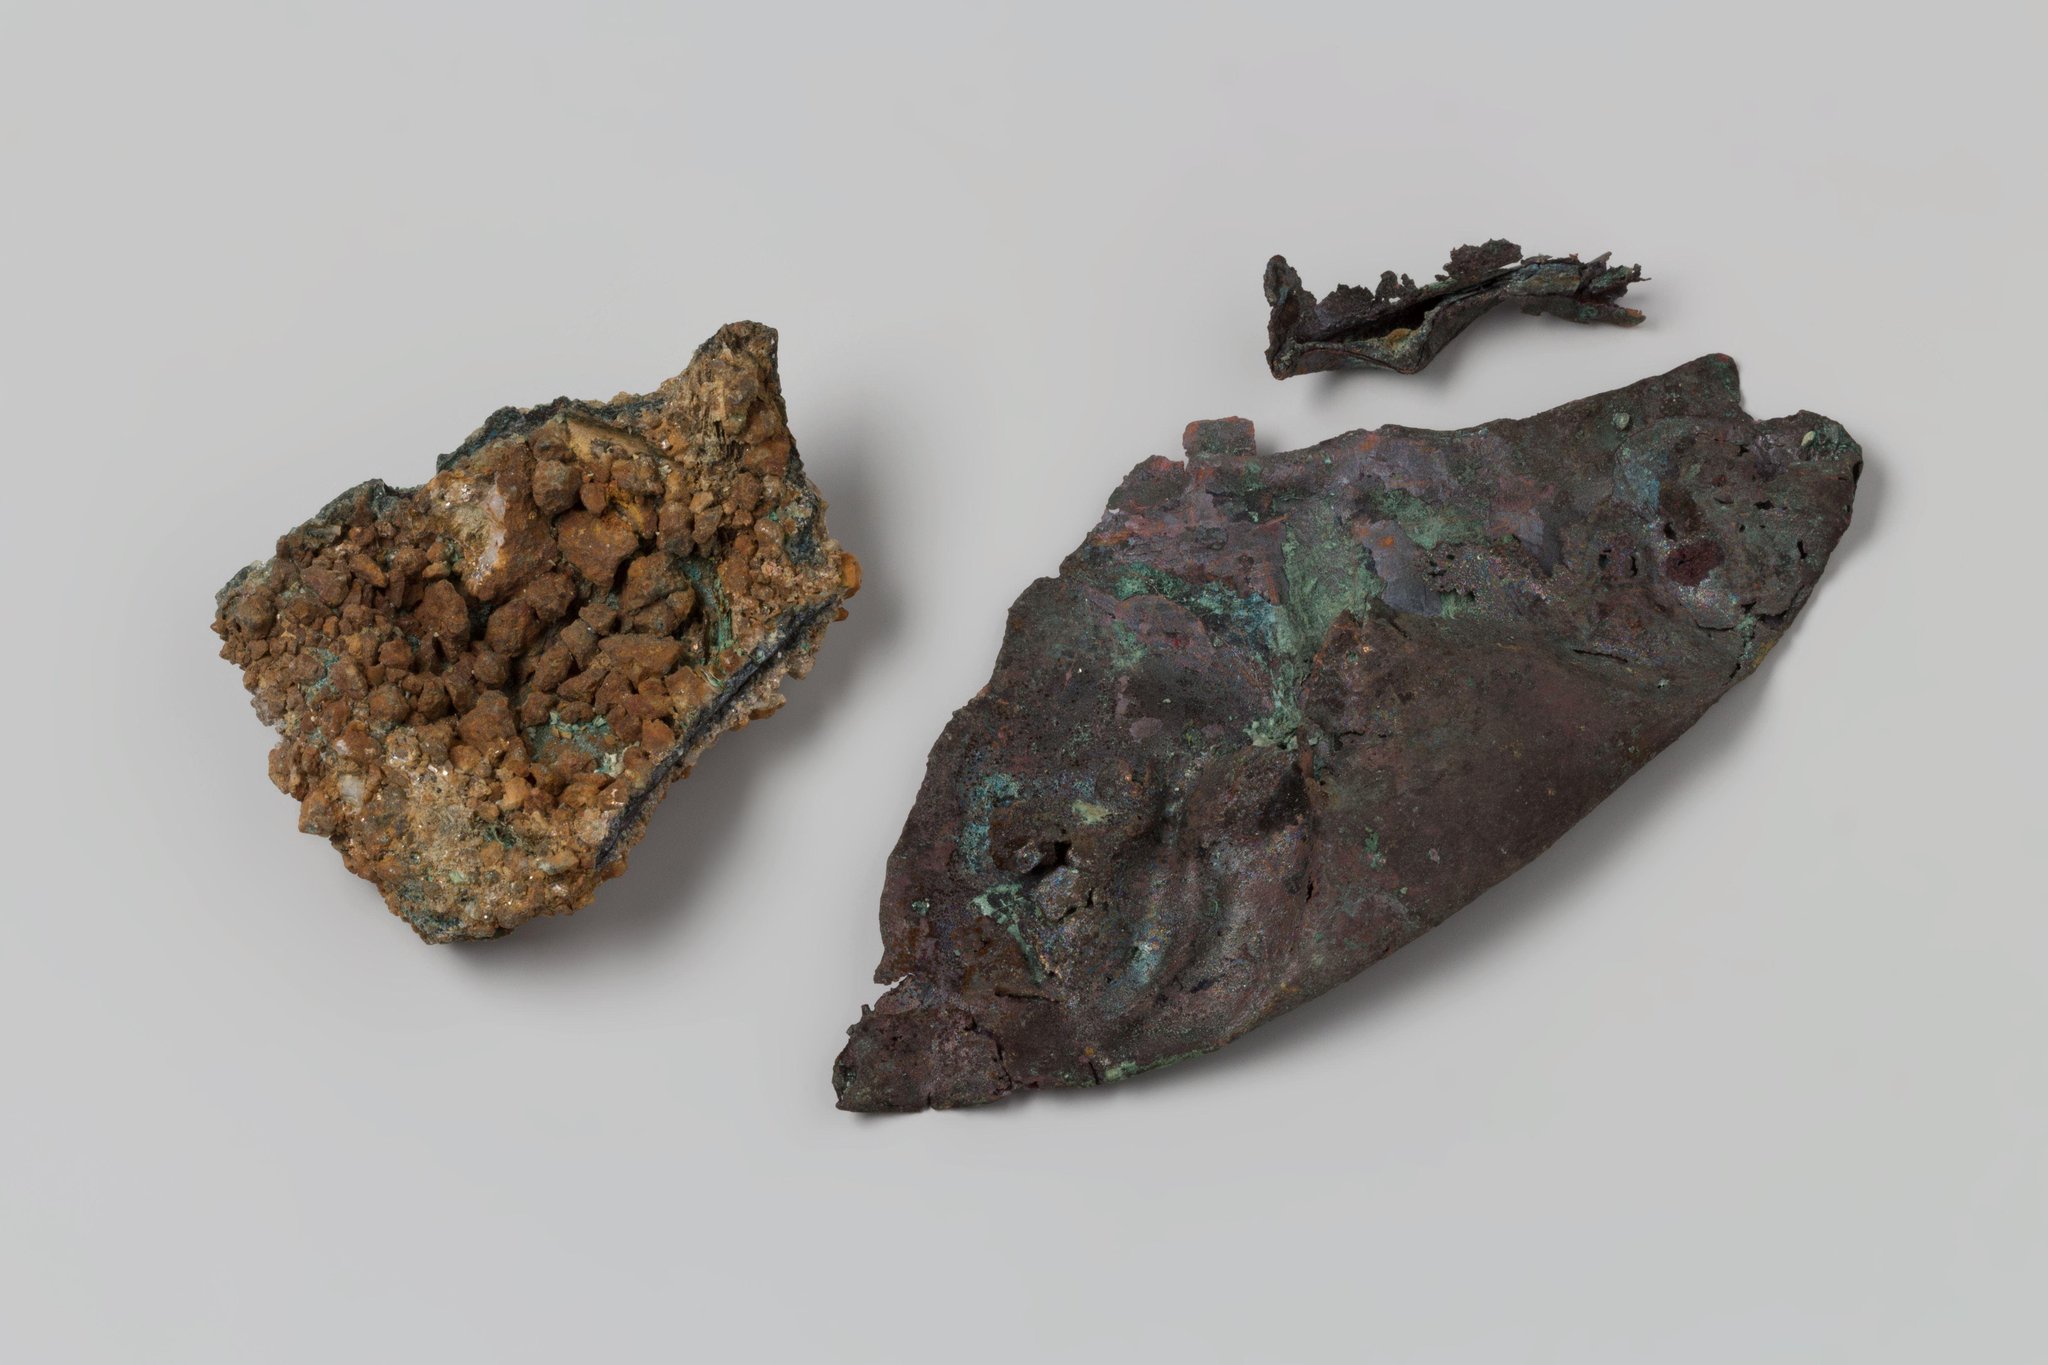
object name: scheepswrakvondst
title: Fragmenten van vaatwerk uit het wrak van de Oost-Indiëvaarder Hollandia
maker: Anonymous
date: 1700-1743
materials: copper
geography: netherlands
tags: verenigde oostindische compagnie, hollandia (schip), annet